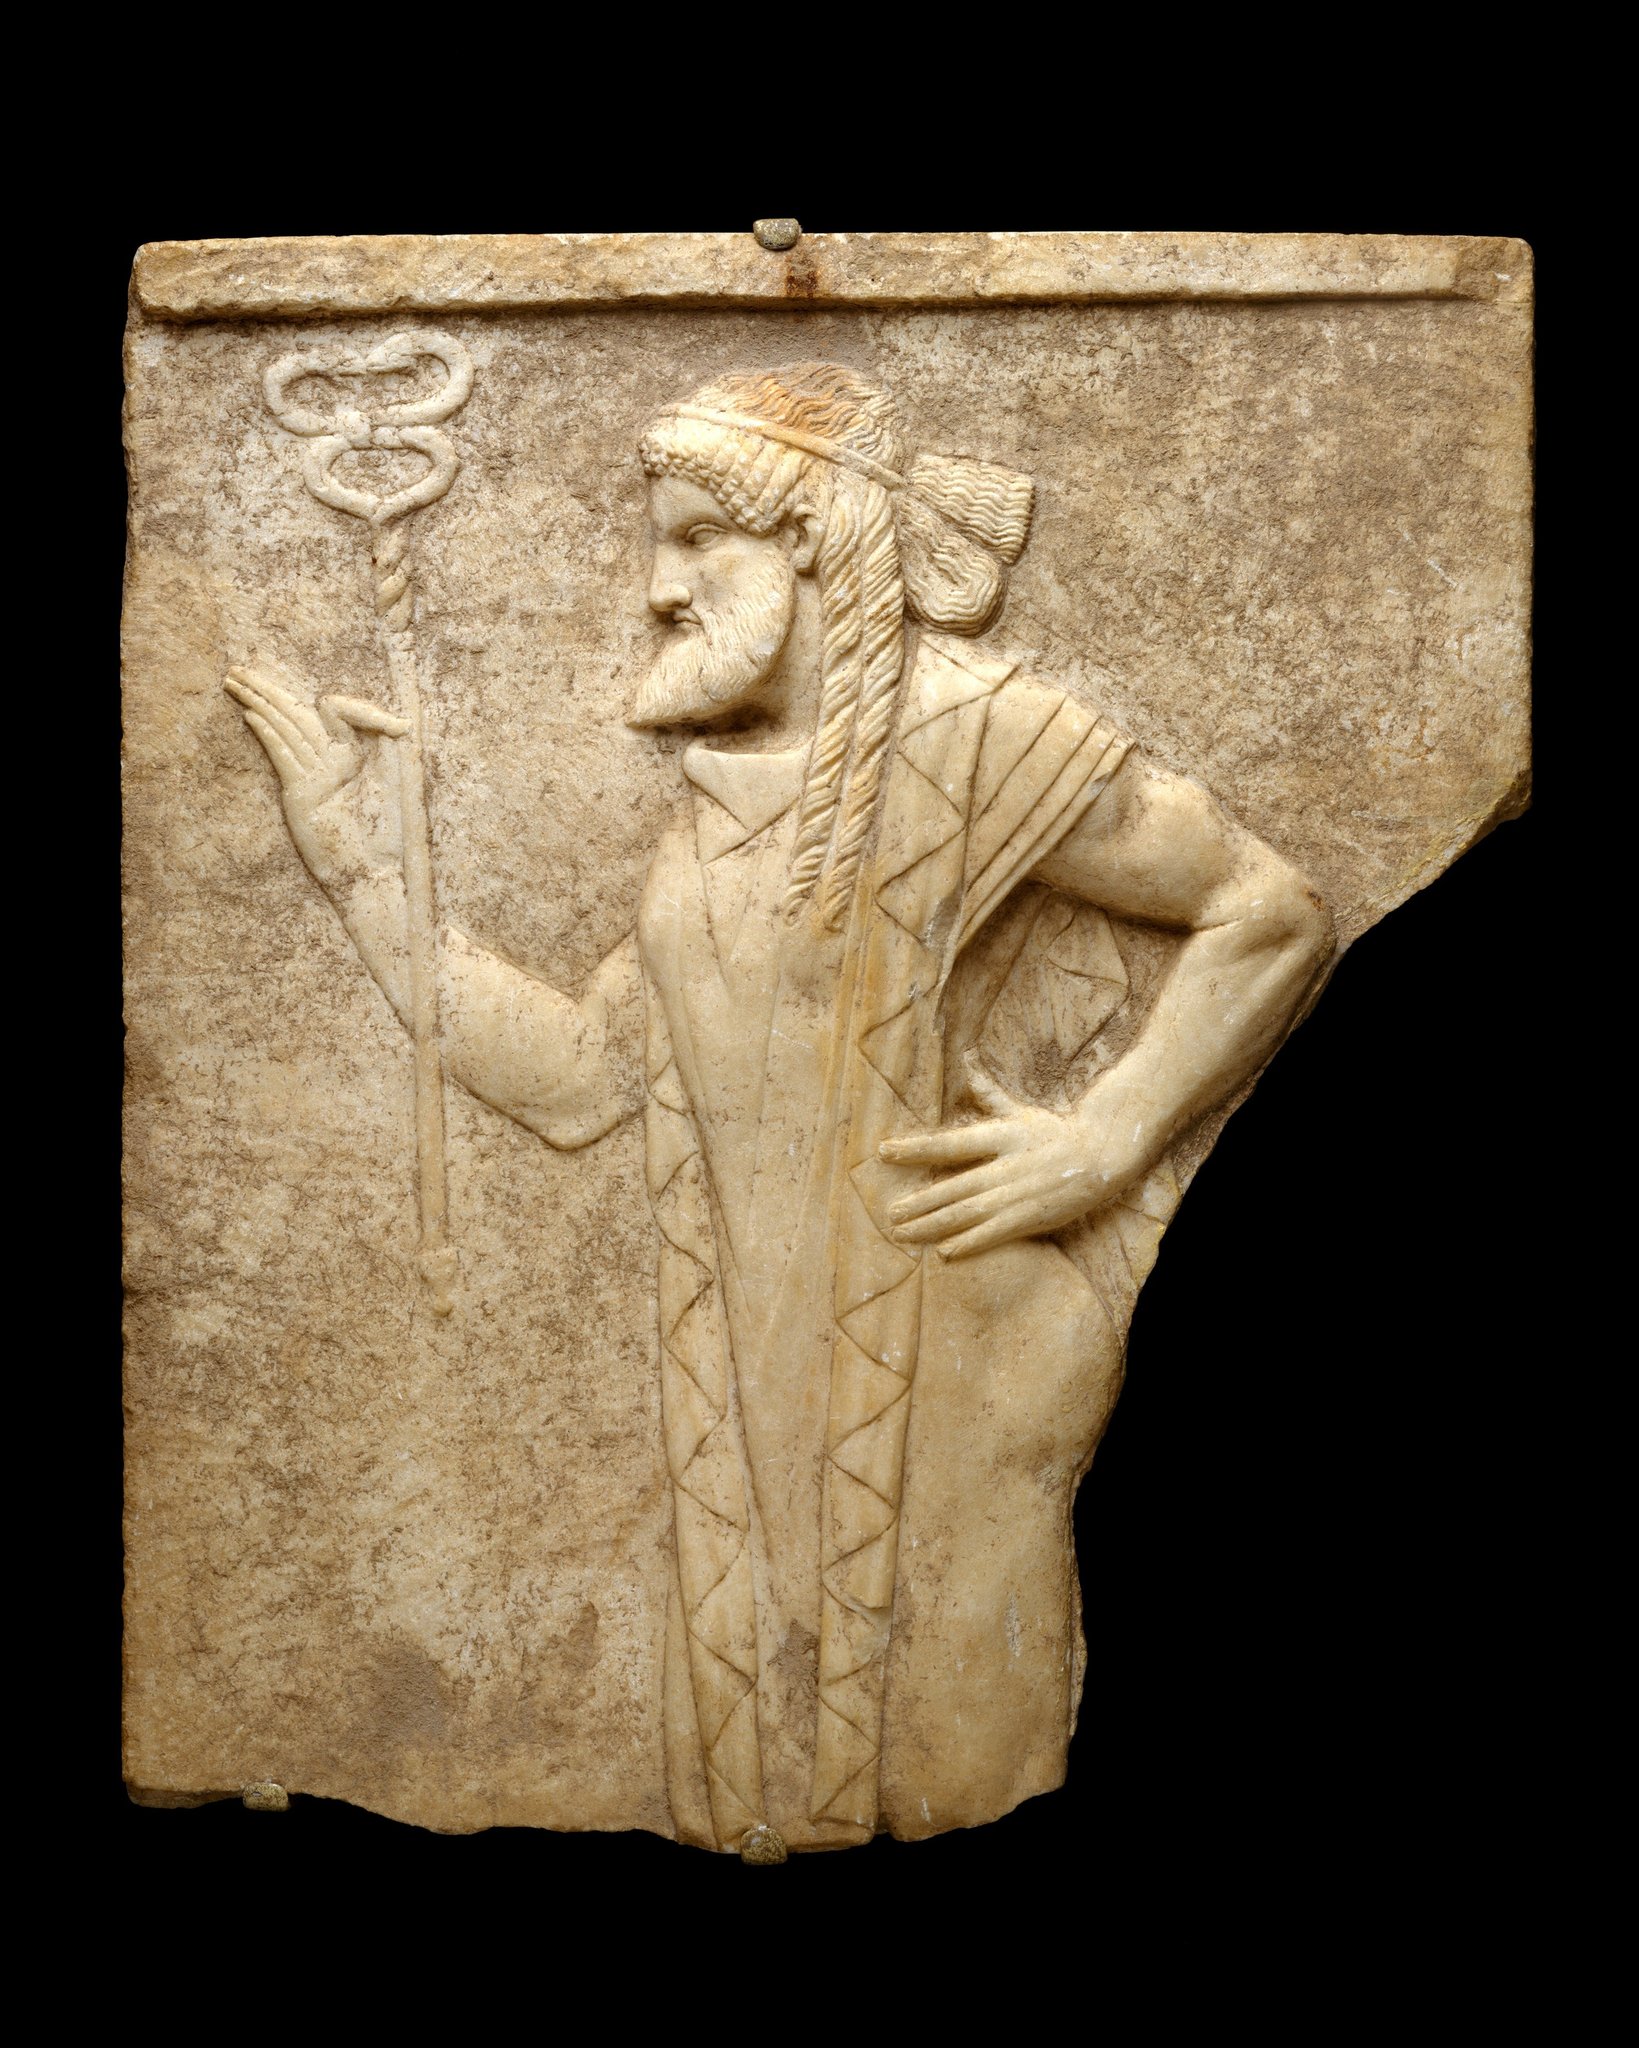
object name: relief of hermes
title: Marble relief with Hermes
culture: roman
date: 27 BCE-68 CE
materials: marble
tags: hermes